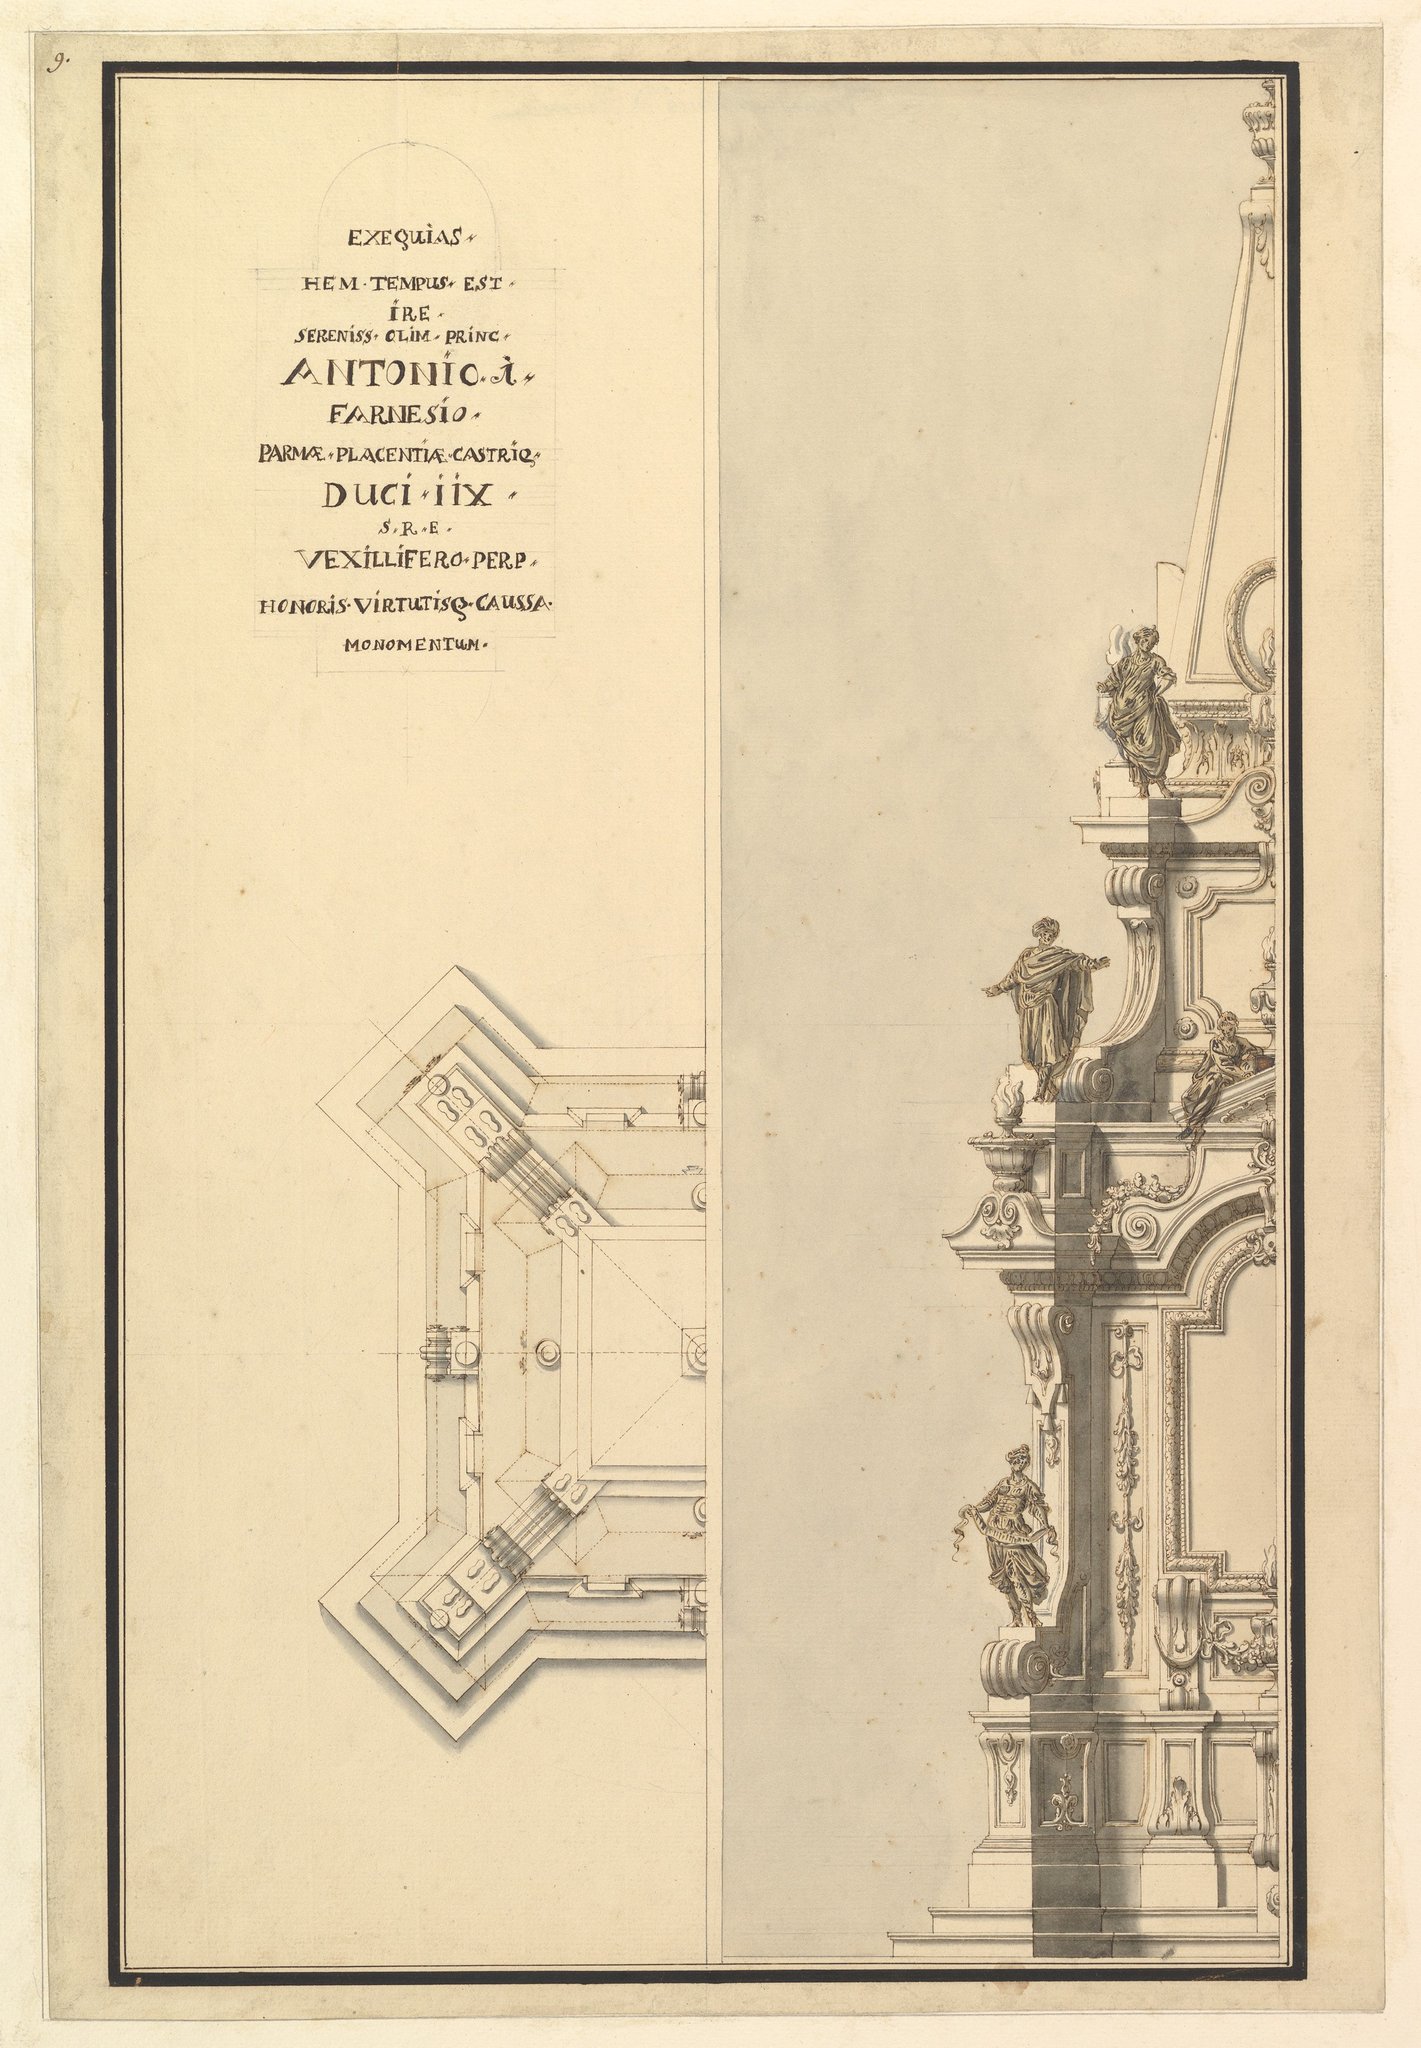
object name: drawing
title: Half Elevation and Half Ground Plan for Catafalque for Antonio Farnese, Duke of Parma (d. 1731)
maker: giuseppe galli bibiena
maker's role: artist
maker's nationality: italian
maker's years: 1696-1756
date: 1731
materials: ink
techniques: pen, wash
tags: architecture